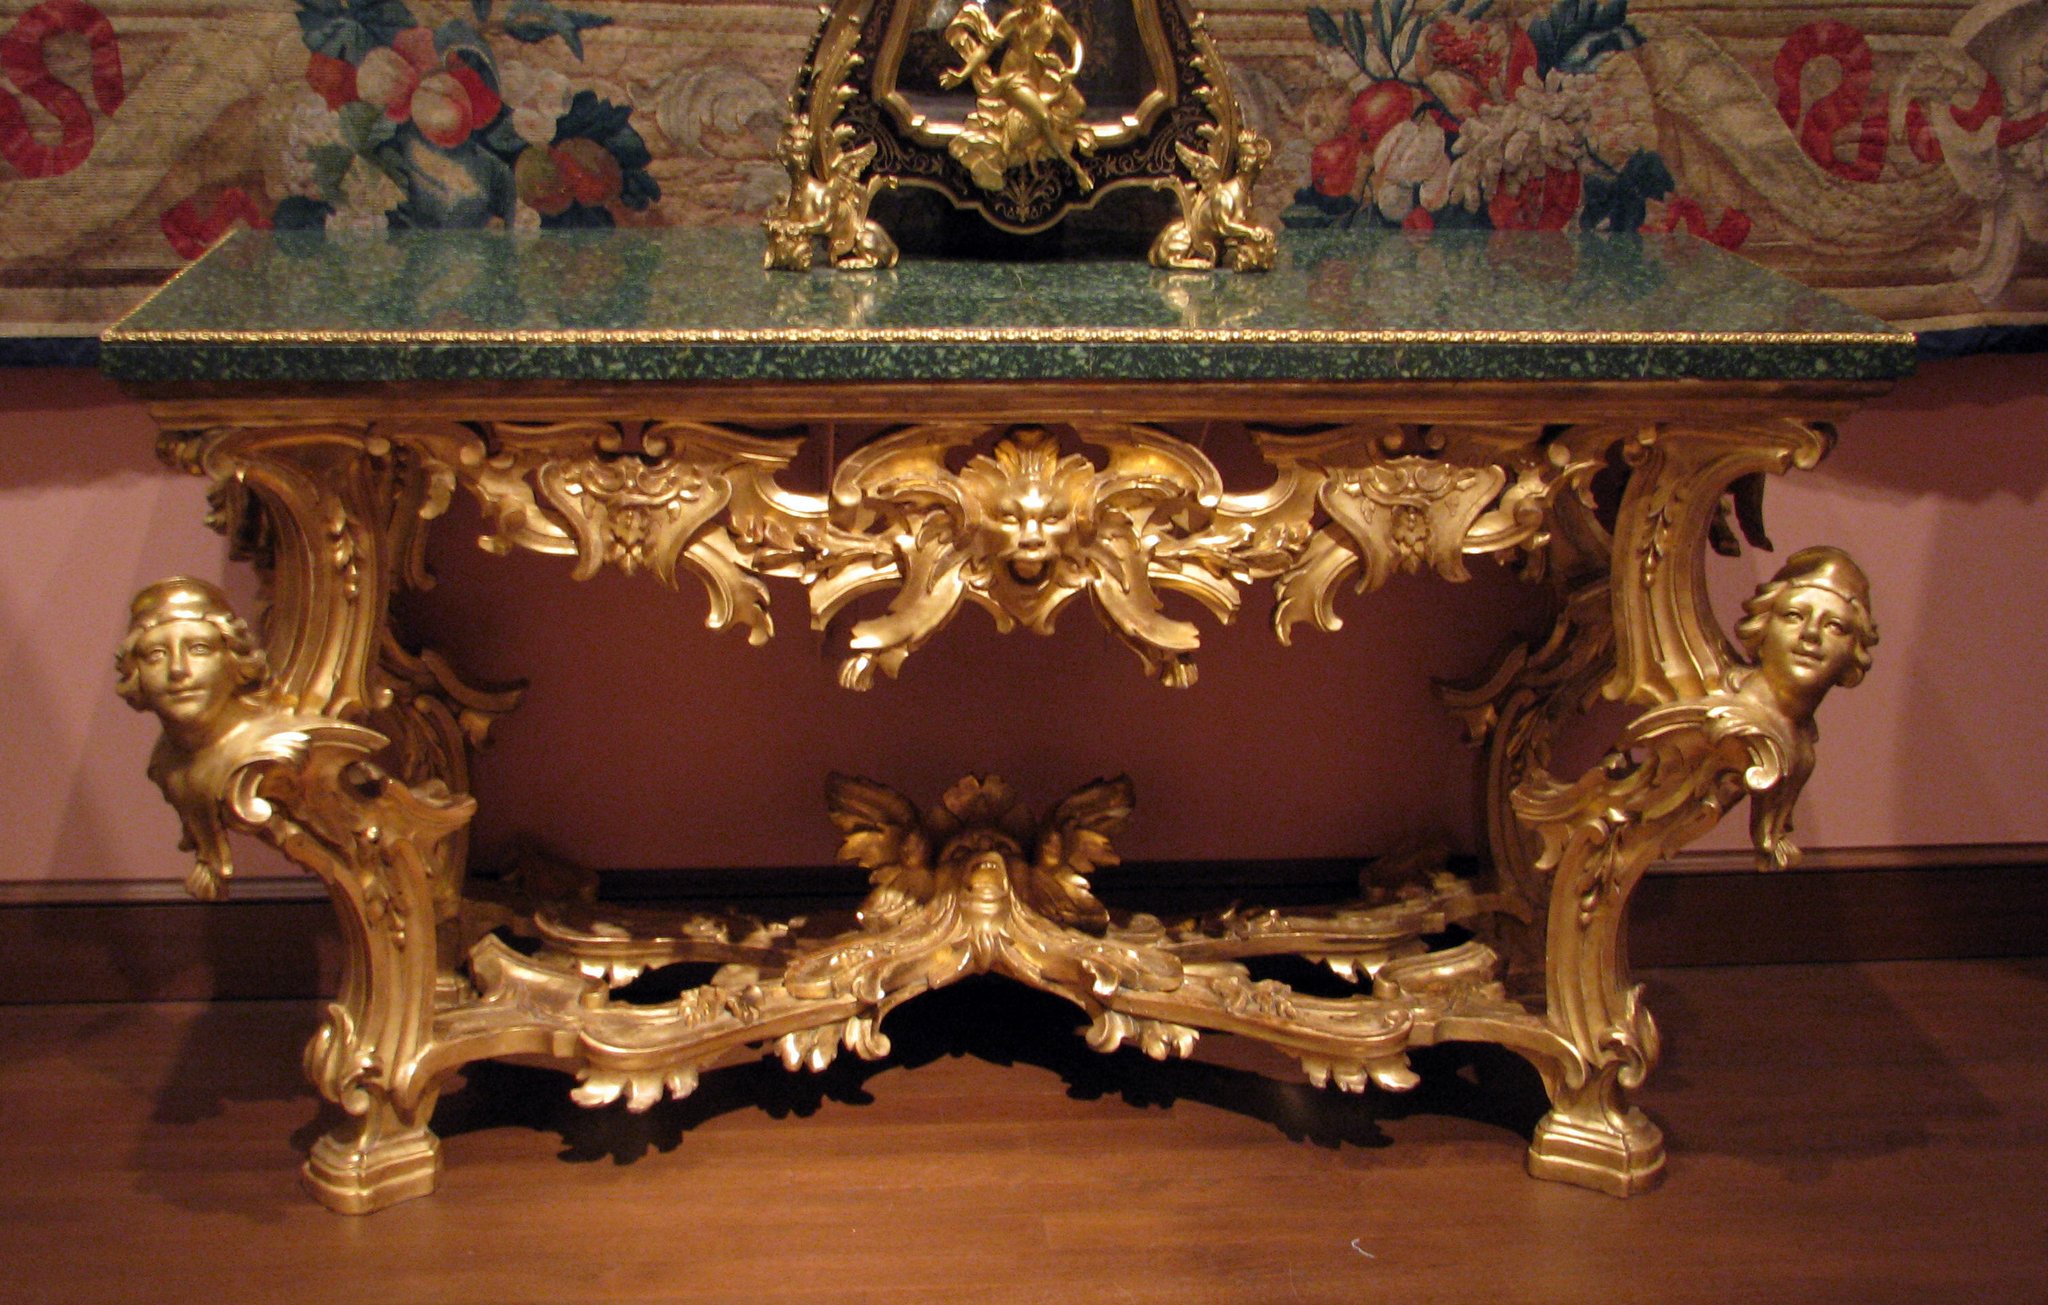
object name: console table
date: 1700-1725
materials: gilt bronze, wood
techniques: gilding